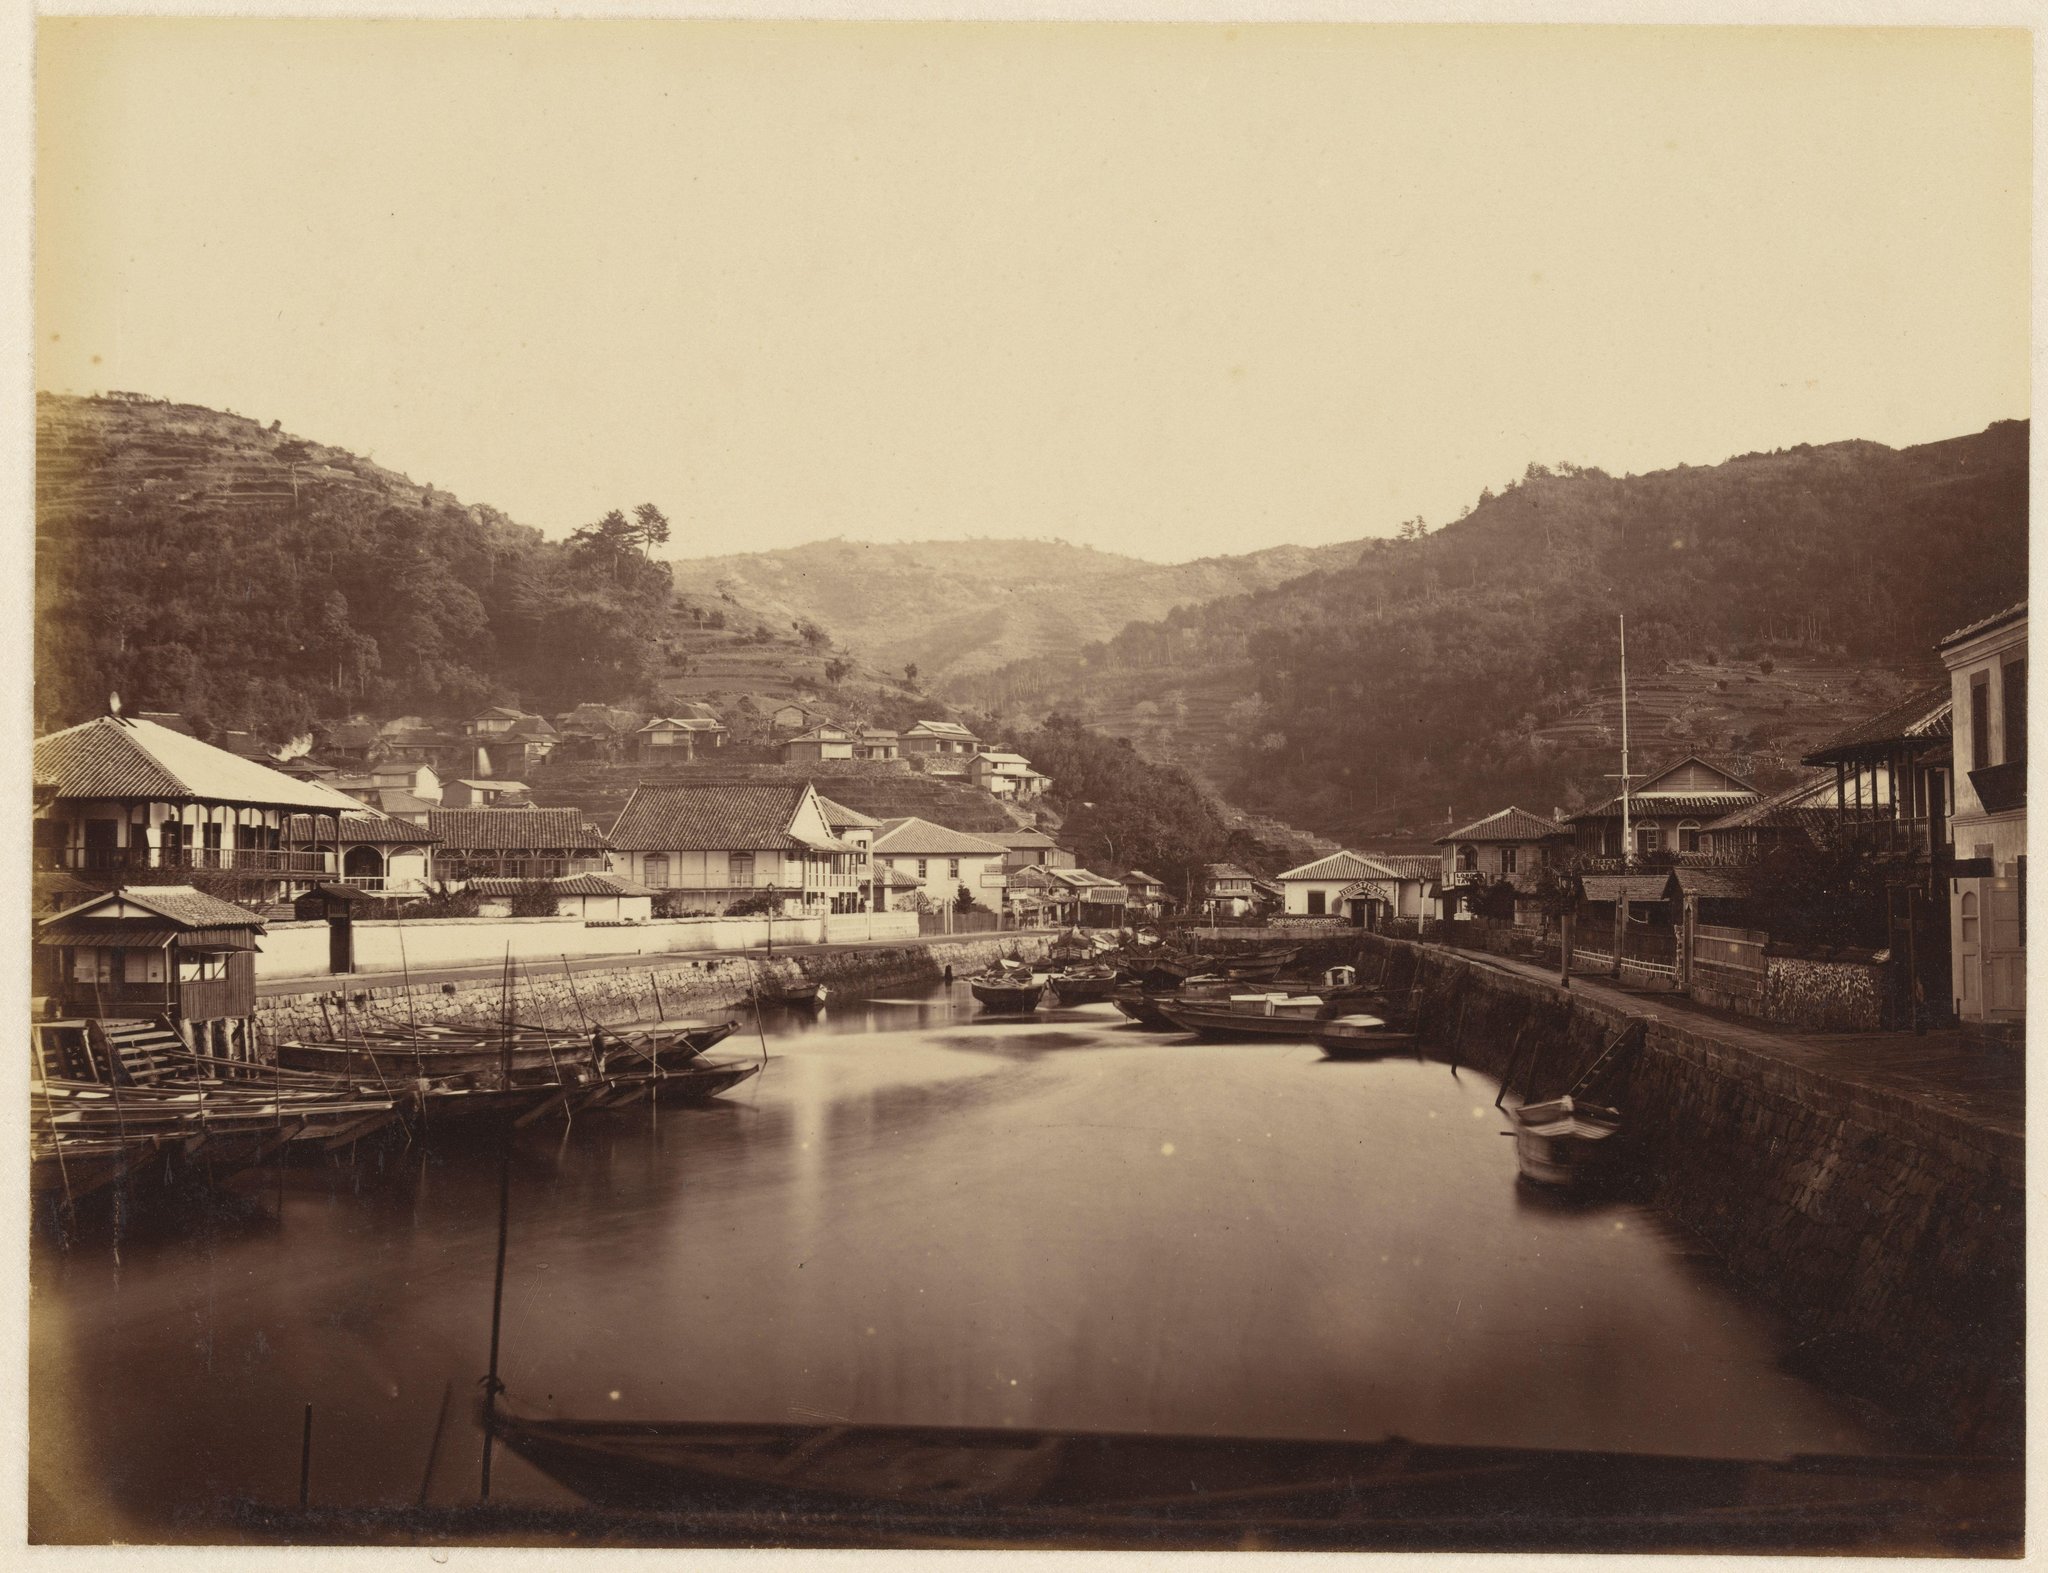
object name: photograph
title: Oura settlement in Nagasaki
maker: Anonymous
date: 1865-1875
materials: paper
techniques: albumen print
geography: japan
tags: japan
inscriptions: number: ‘BD196’, number: ‘N7’, number: ‘BL6’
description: In the period that the Bauduins were in Japan, Dejima was no longer the only place they could live. Dutch and other foreigners settled in a new neighbourhood called Oura. It is not clear precisely when this picture was taken. It may not have been until after 1870, when Antoon returned to the Netherlands. Possibly, it was Albert who took it home.